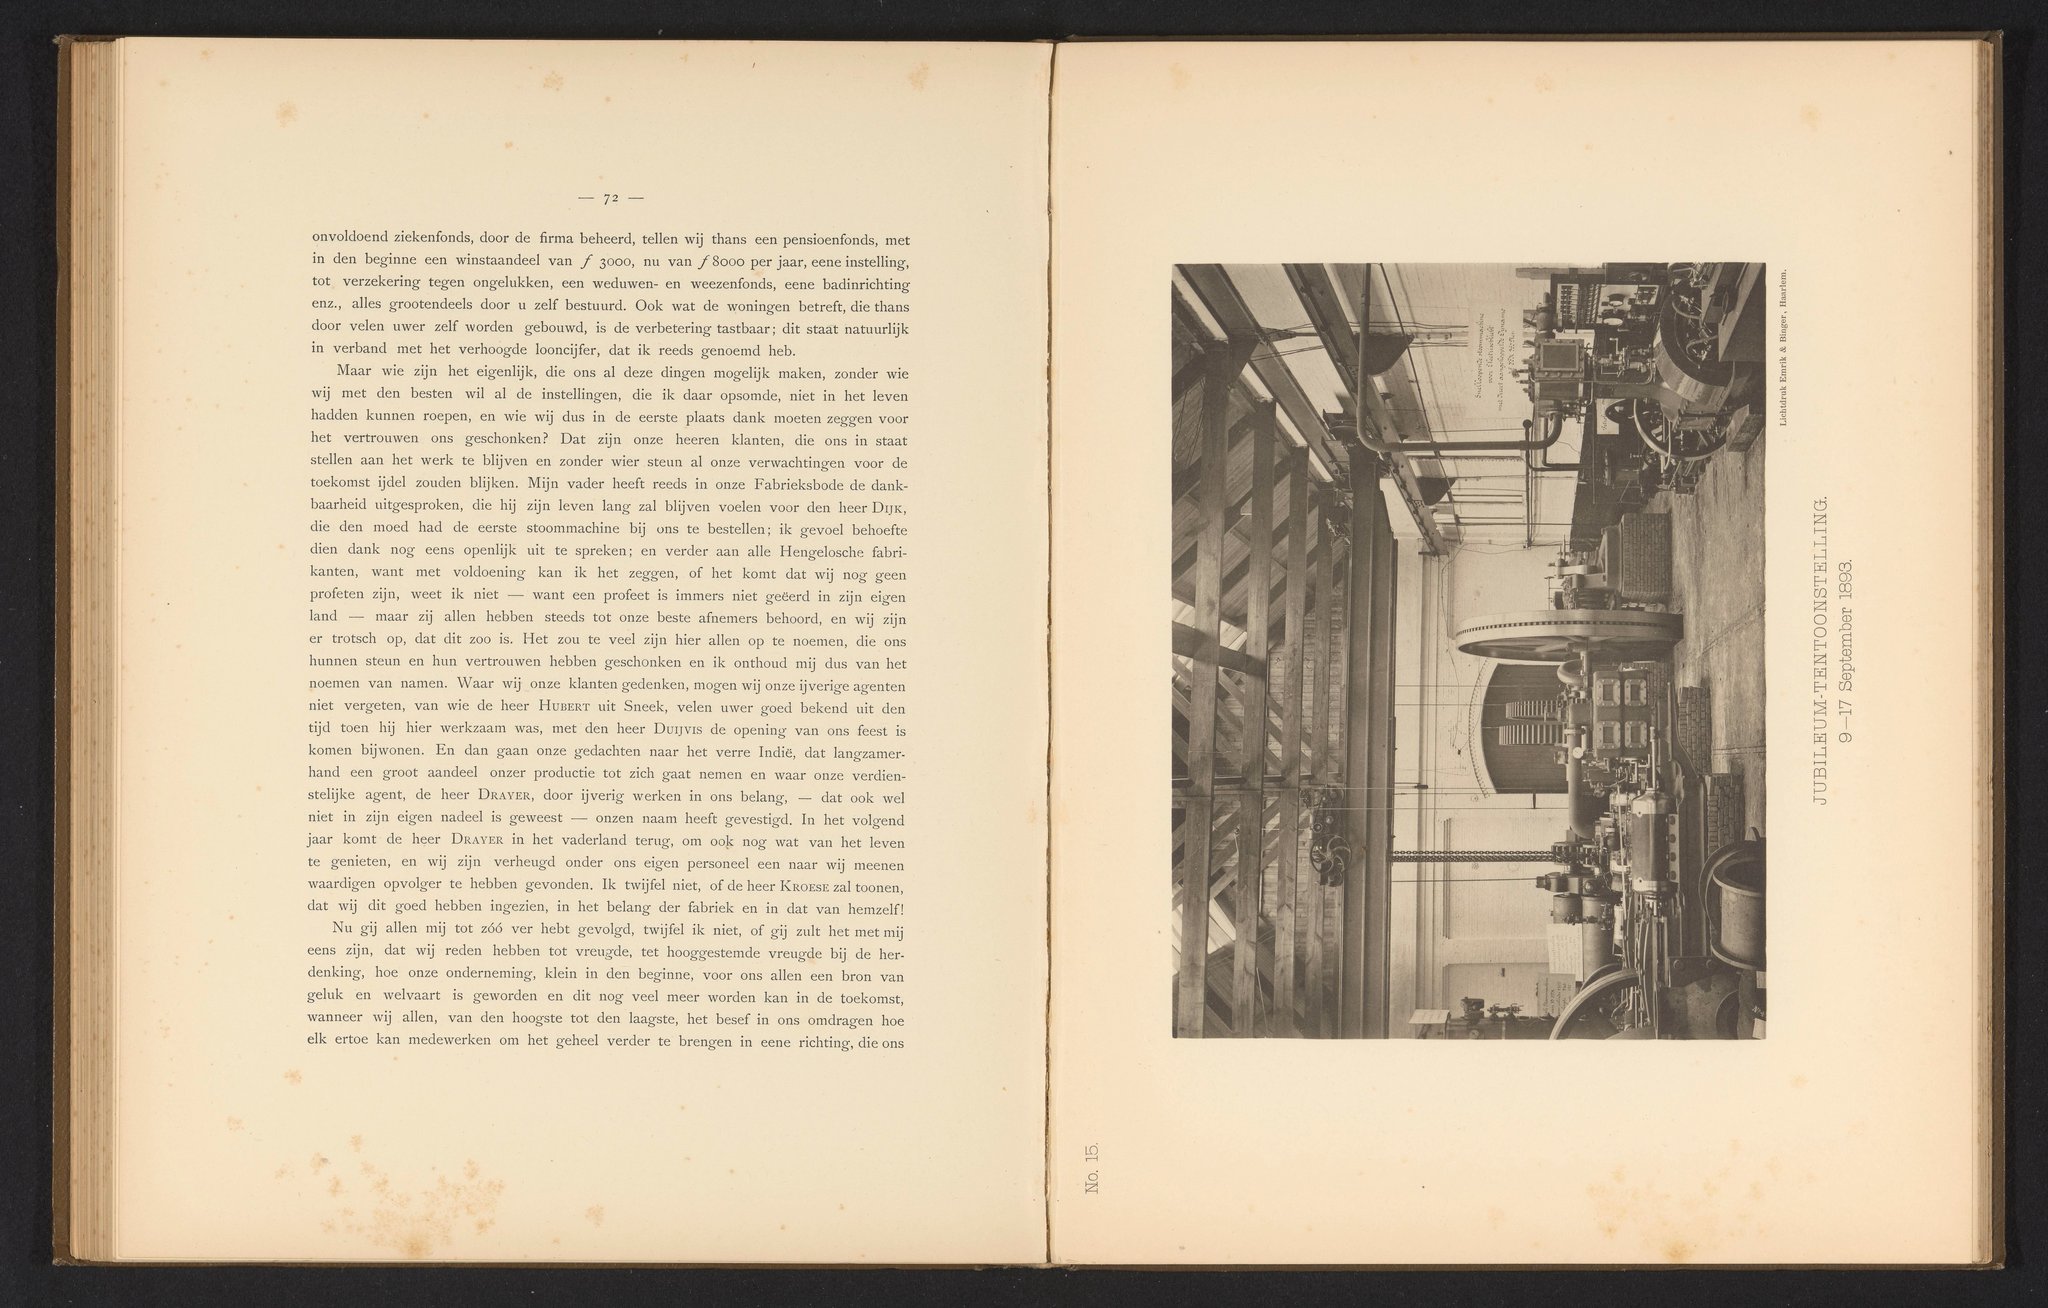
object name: photomechanical print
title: Jubileum-Tentoonstelling. 9-17 September 1893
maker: Anonymous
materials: paper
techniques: photograph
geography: haarlem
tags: factory-interior, machine shop, collection, exhibition, show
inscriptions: number: ‘No. 15.’